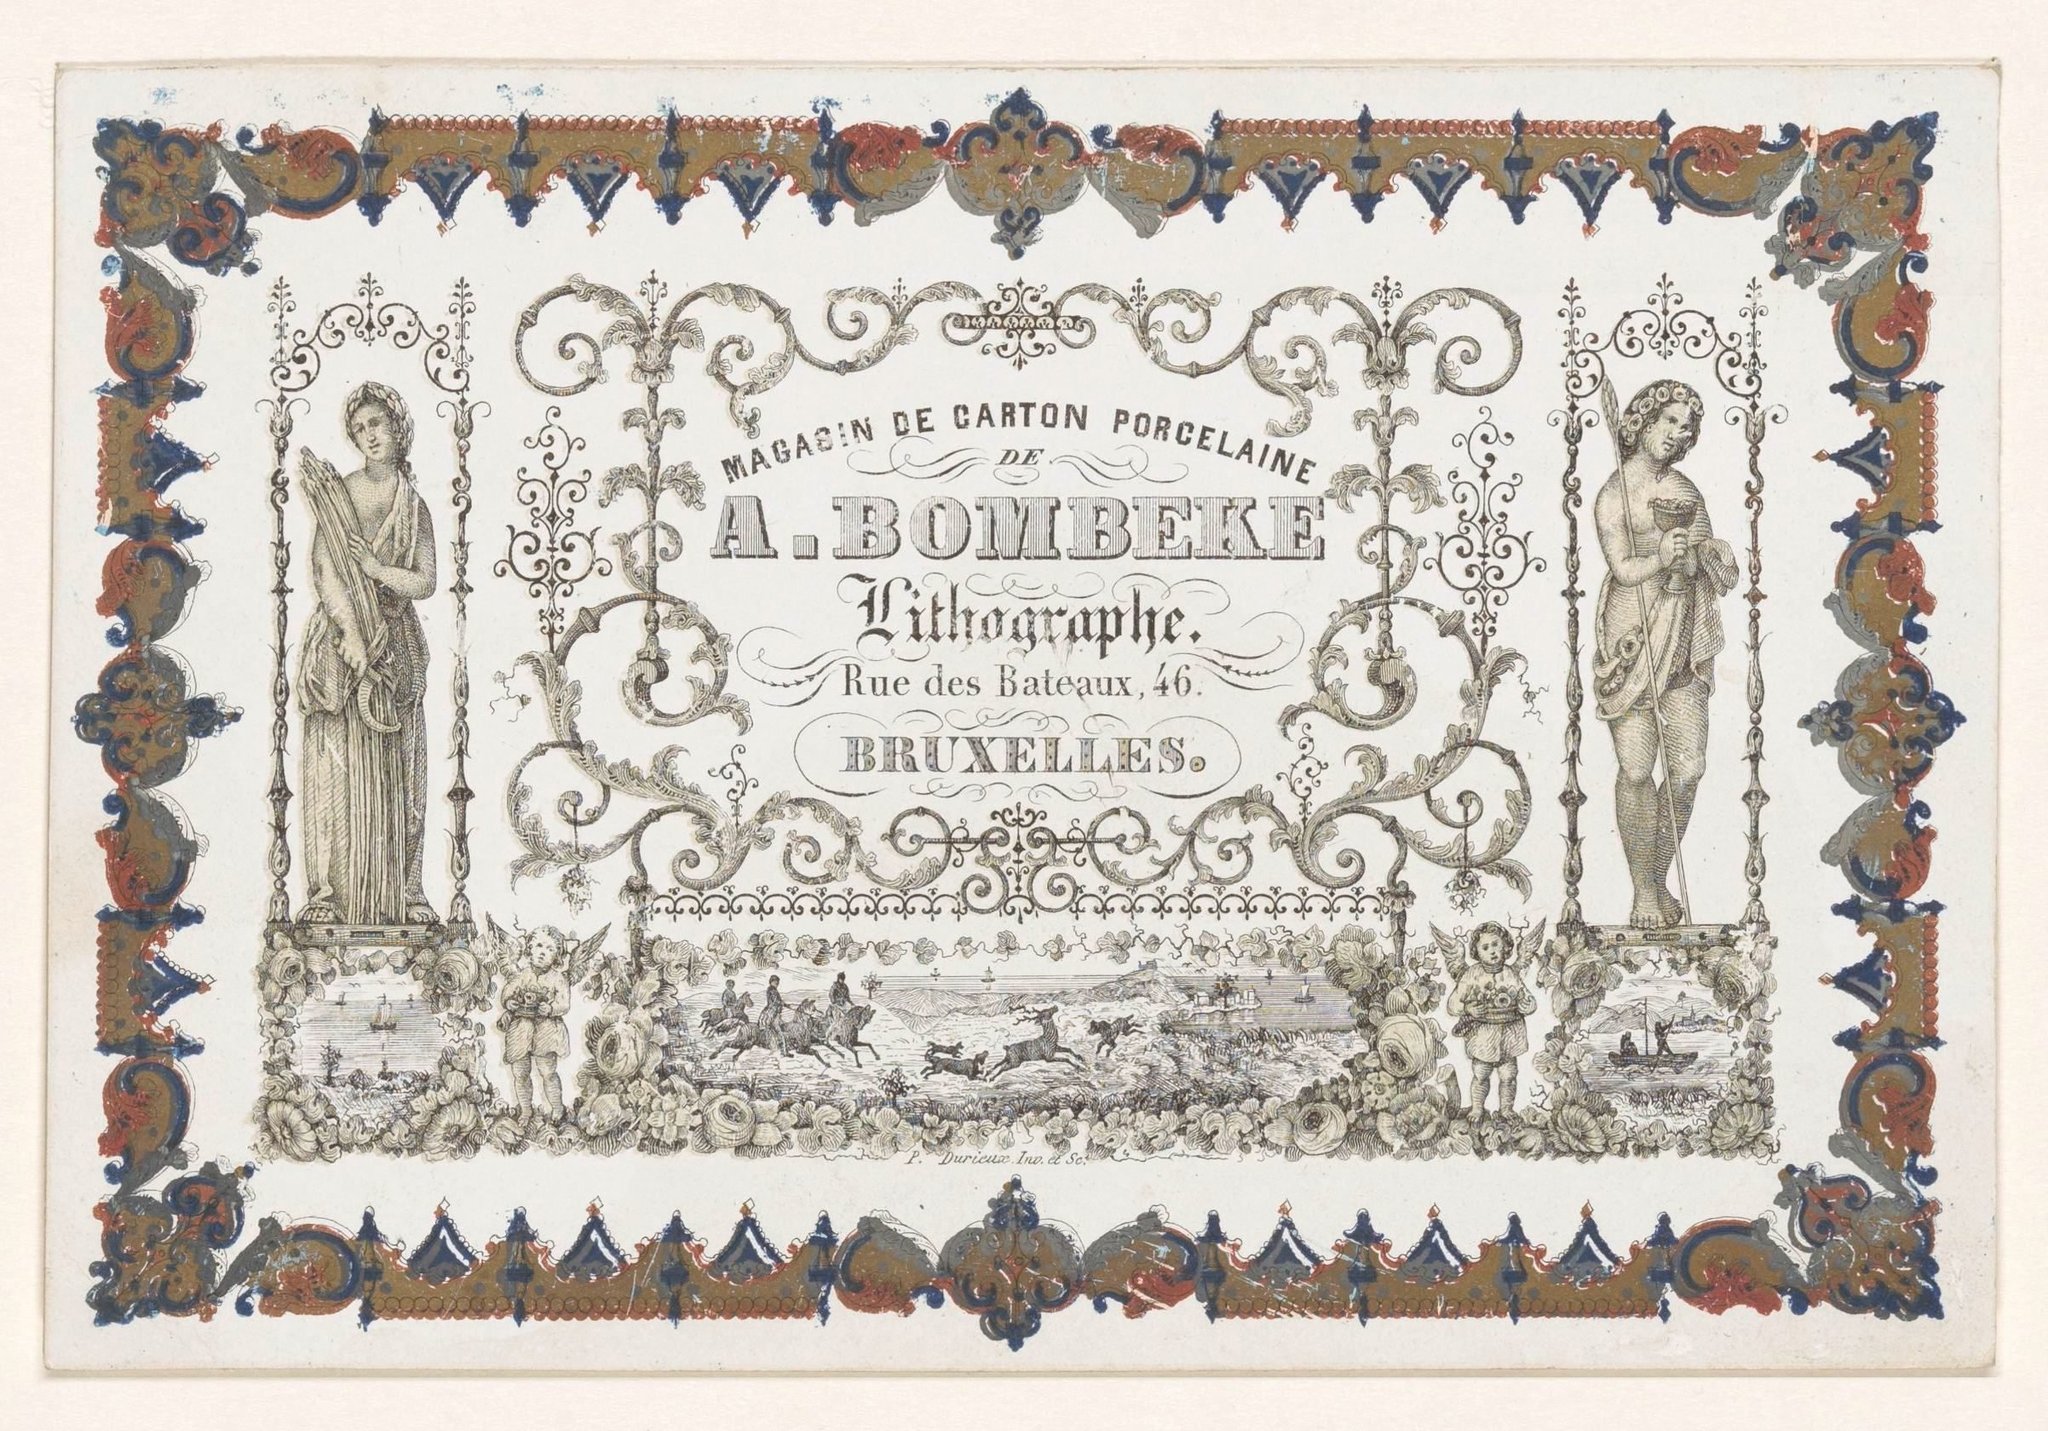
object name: visiting card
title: Visitekaartje van drukkerij Augustin Bombeke te Brussel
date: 1842-1854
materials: porcelainized cardboard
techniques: lithograph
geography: brussels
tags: lithographer, stag-hunting, specific aspects, allegorical aspects of bacchus; bacchus as patron, cupids: 'amores', 'amoretti', 'putti', ceres, patroness of agriculture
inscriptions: collector's mark: Lugt 2228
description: Omlijsting met Ceres en Bacchus, midden onder een jachttafereel geflankeerd door putti, in beide hoeken een gezicht op een meer met boten.